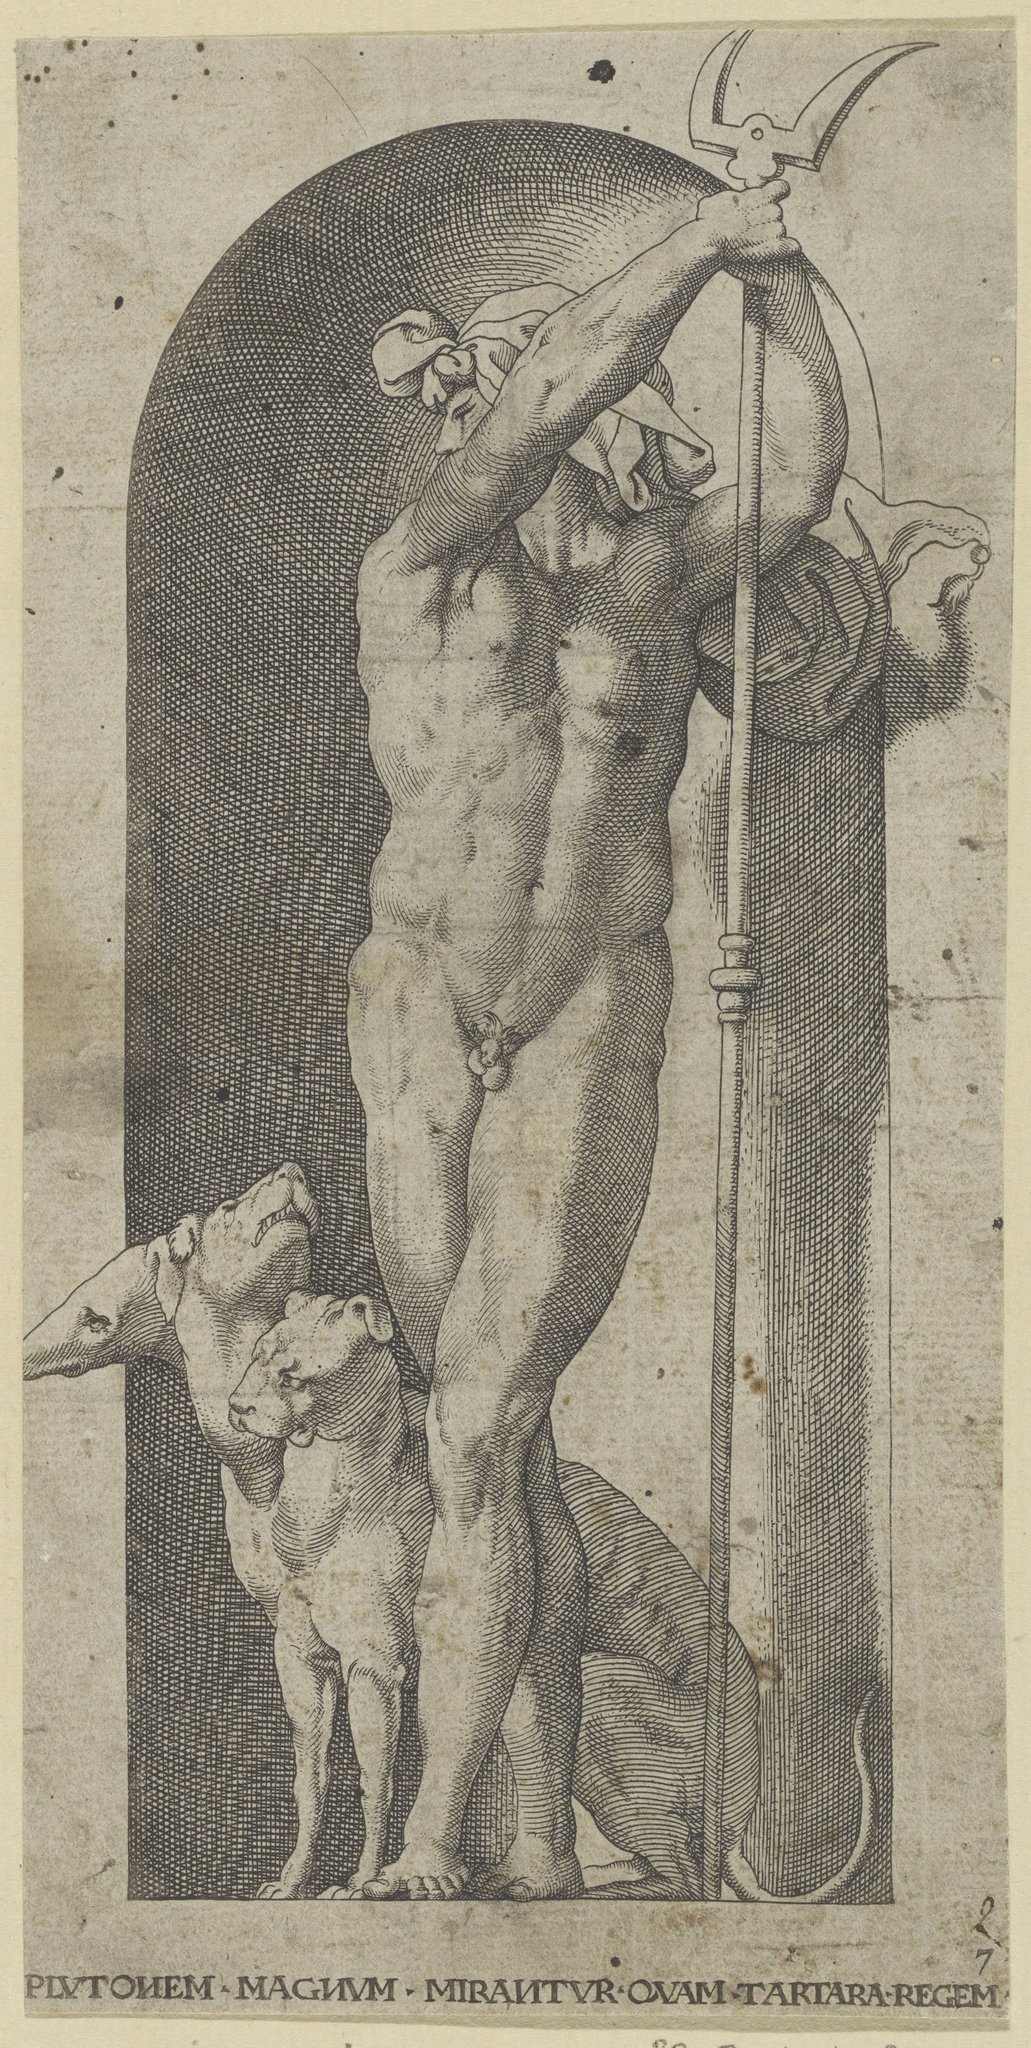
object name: print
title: Plutonem magnum mirantur quam tartara regem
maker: jacob binck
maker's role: painter, print maker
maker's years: 1494-1569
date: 1510-1569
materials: paper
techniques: engraving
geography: italy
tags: (story of) pluto (hades), dis pater, orcus, cerberus, the three- or many-headed dog; 'cerbero' (ripa)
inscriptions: collector's mark: Lugt 11, number: ‘2’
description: De god Pluto staat met de Cerberus in een nis. Genummerd rechtsonder: 7.